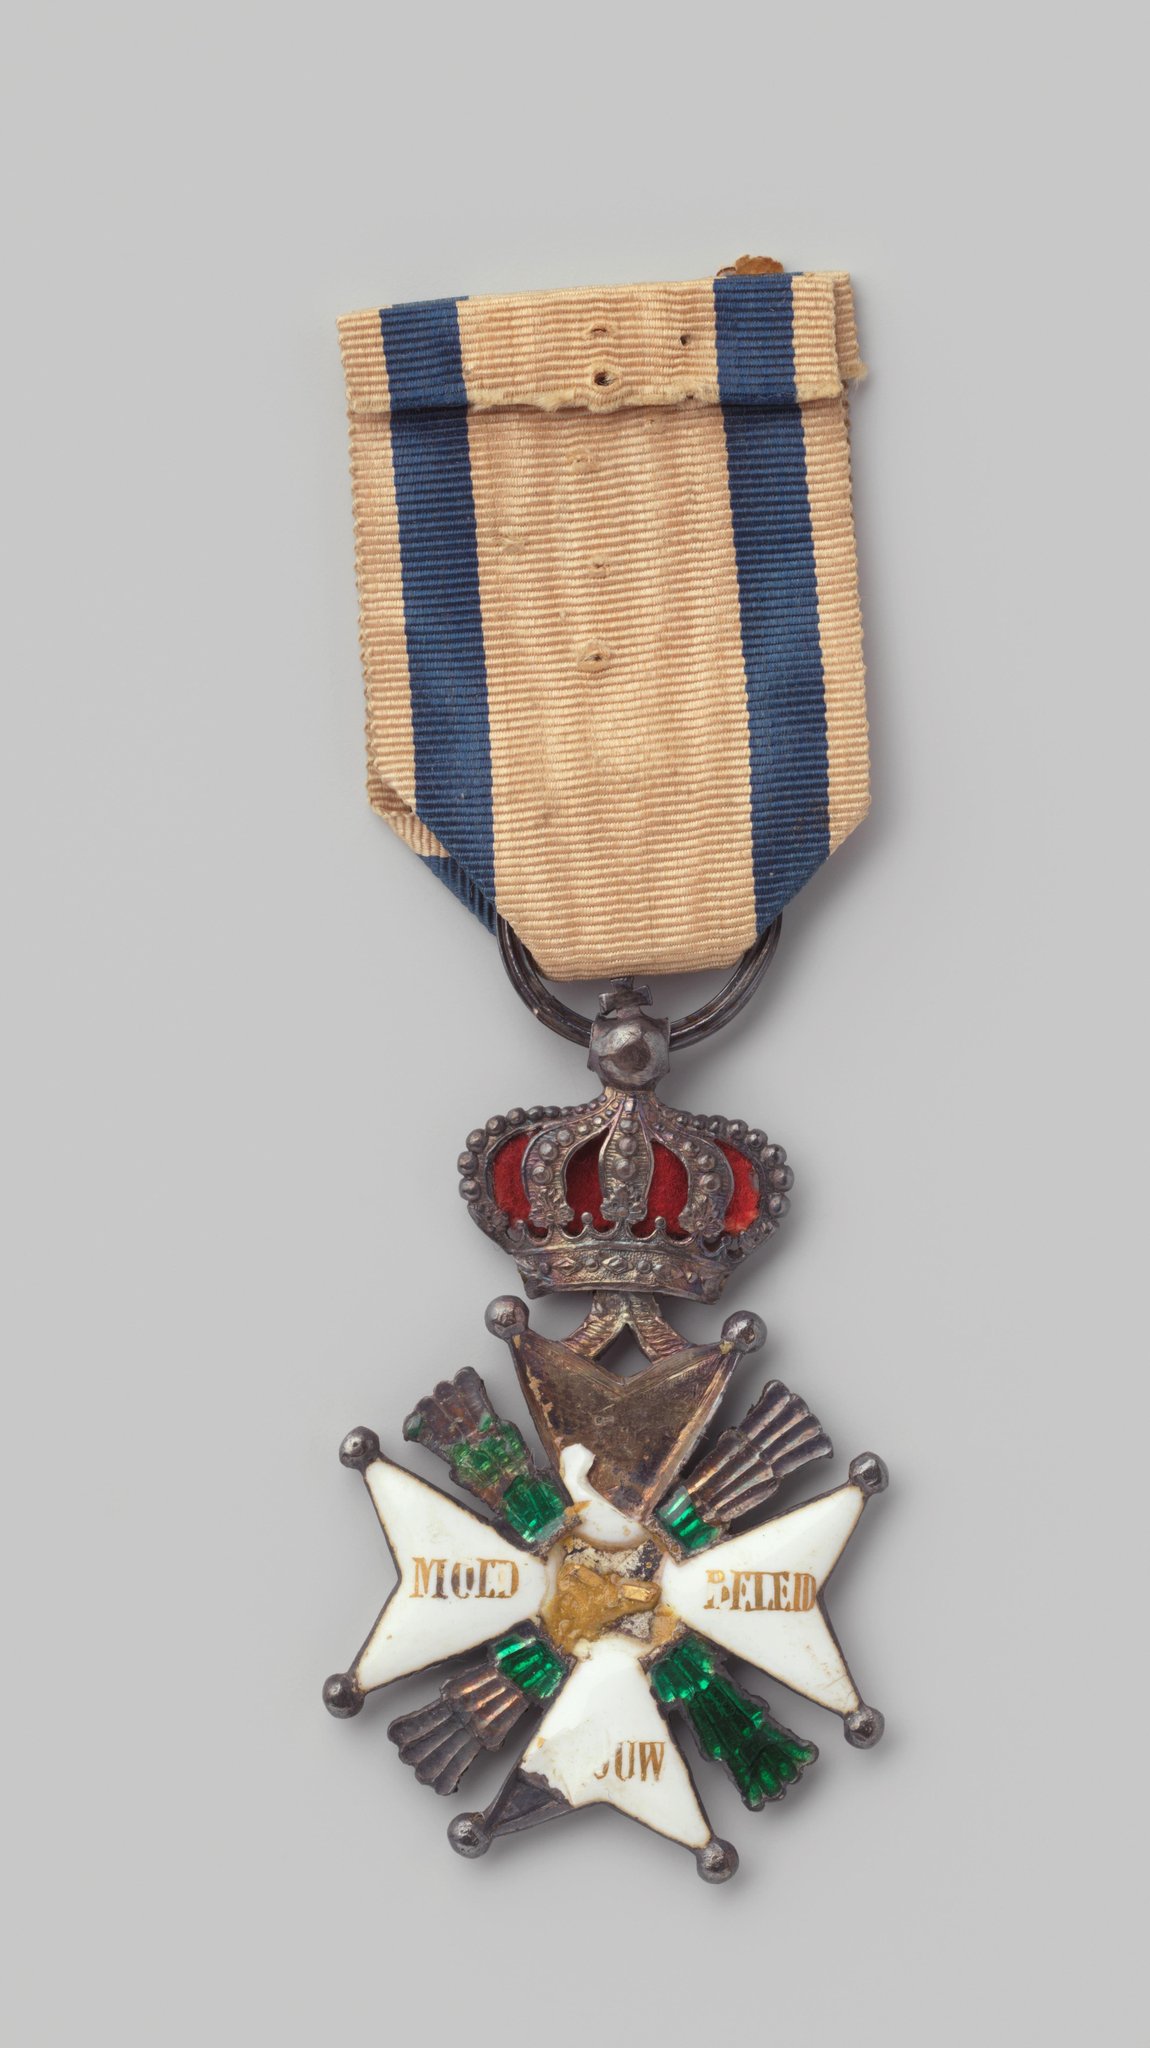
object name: onderscheidingsteken, onderscheiding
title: Militaire Willems-Orde Ridder 4e klasse aan lint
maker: Anonymous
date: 1815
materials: iron, silver, textile, wax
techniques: striking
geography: netherlands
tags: militaire willemsorde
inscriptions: : ‘MOED/ BELEID/ TROUW’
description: Militaire Willems-Orde Ridder 4e klasse aan groen/oranje lint. Het lint heeft aan de buitenzijden twee groene strepen op een oranje maar tot wit verbleekt lint. Het zit vast aan een metalen ring welke bevestigd is aan de onderscheiding. De Militaire Willems-Orde bestaat uit een Maltezer kruis waarvan de armen wit geëmailleerd zijn en de uiteinden zilveren balpunten hebben. Tussen de armen groen geëmailleerde versieringen. In het midden een goudkleurige vuurslag. Aan de bovenkant een ijzeren kroon die gevuld is met rode was. Op de armen de woorden MOED, BELEID, TROUW.